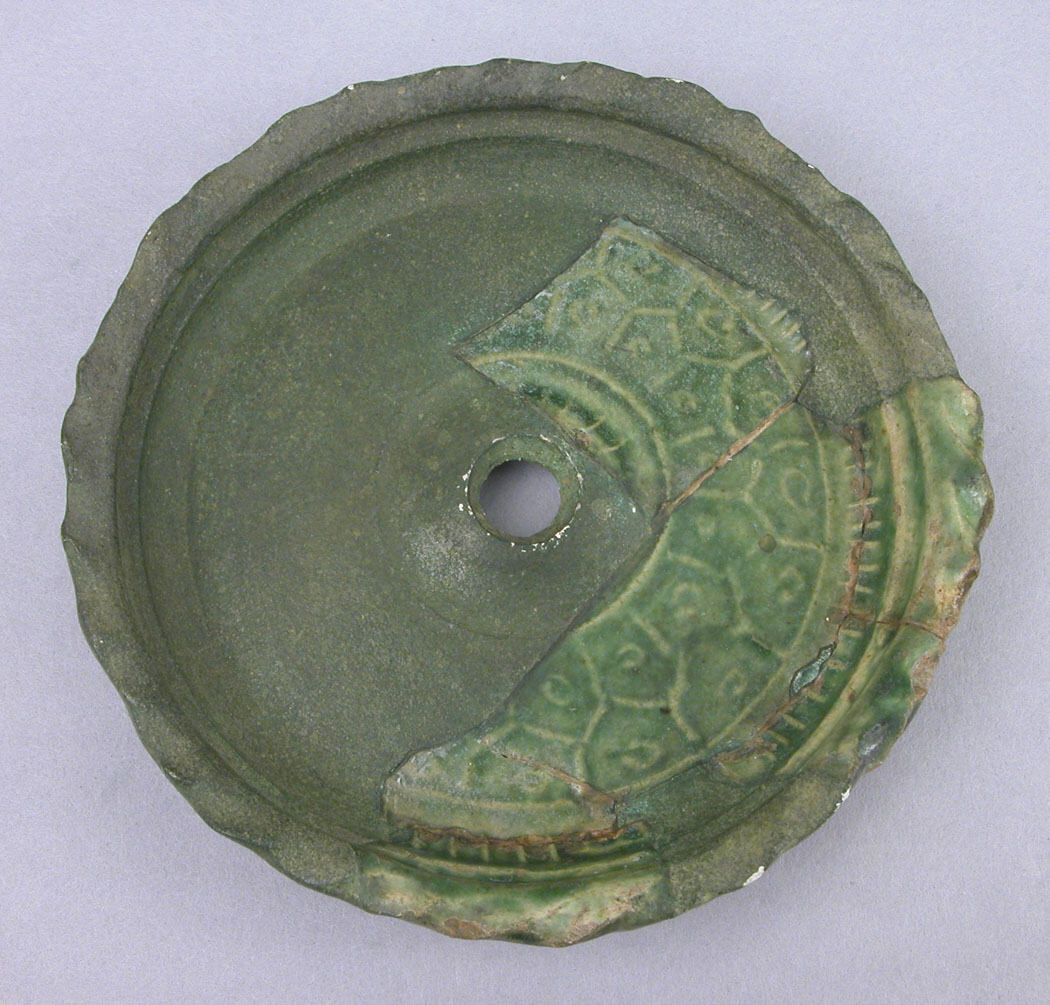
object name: lid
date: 701-900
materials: earthenware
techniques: glazing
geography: iran